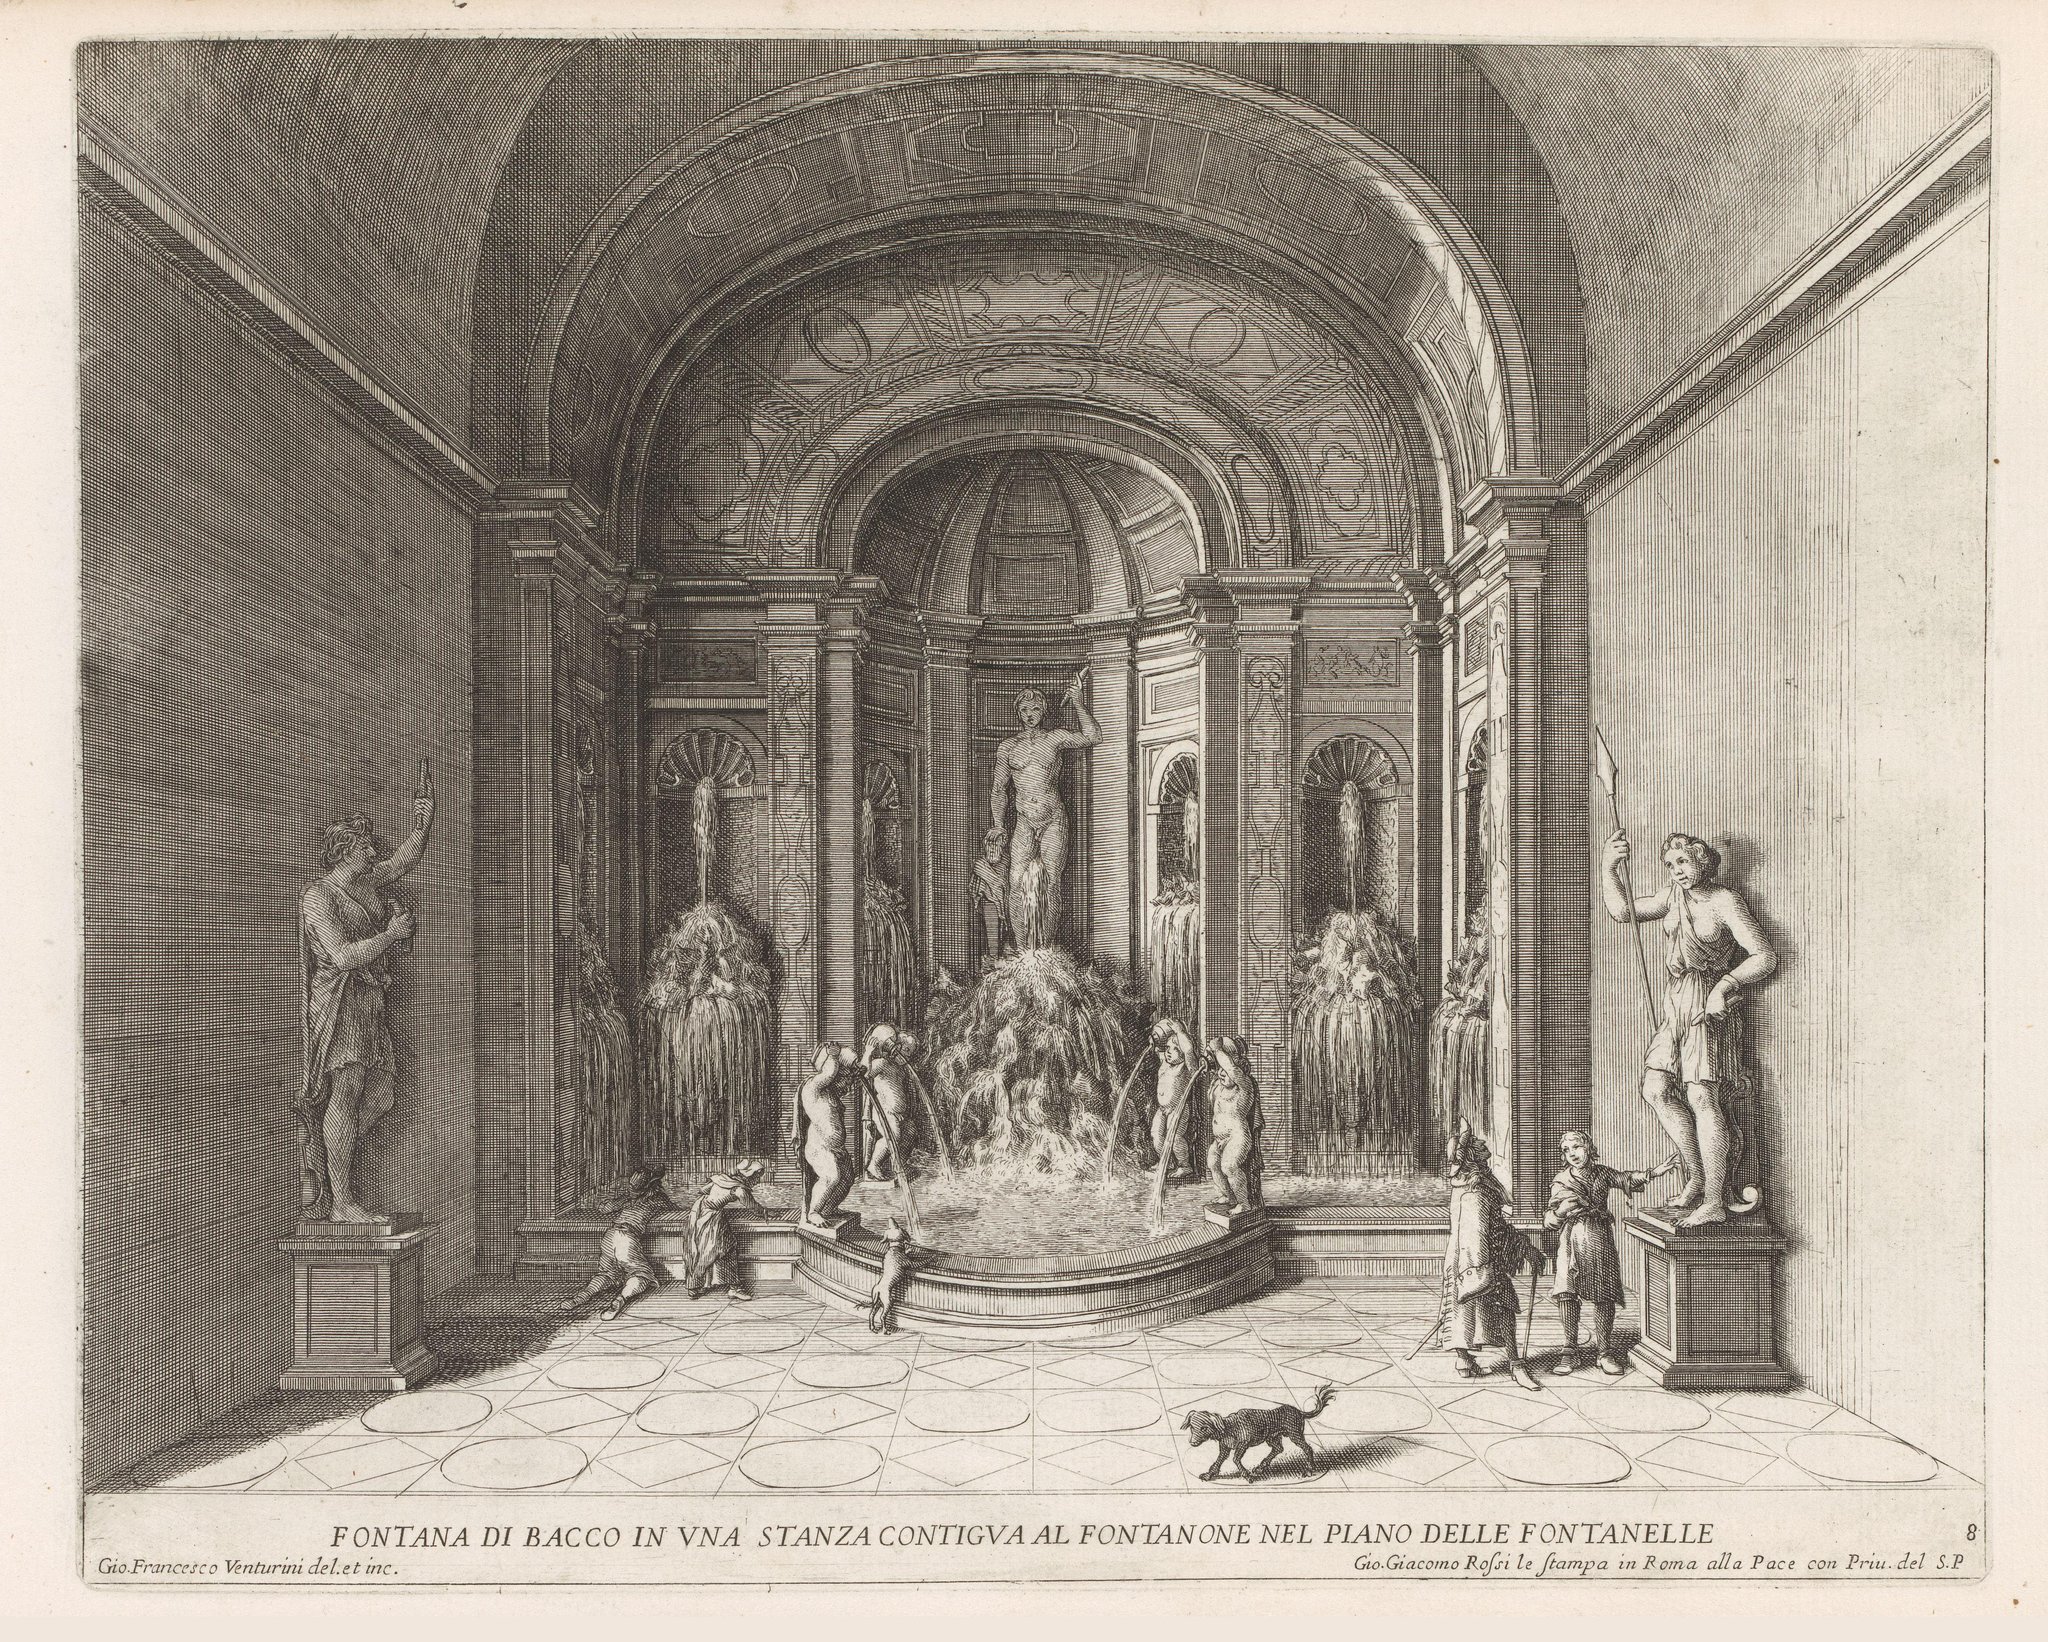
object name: print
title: Le fontane del giardino Estense in Tivoli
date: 1653-1691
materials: paper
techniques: etching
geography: vatican city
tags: (story of) bacchus (dionysus), liber, ornamental fountain, tivoli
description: Genummerd rechtsonder: 8. De prent maakt deel uit van een album.